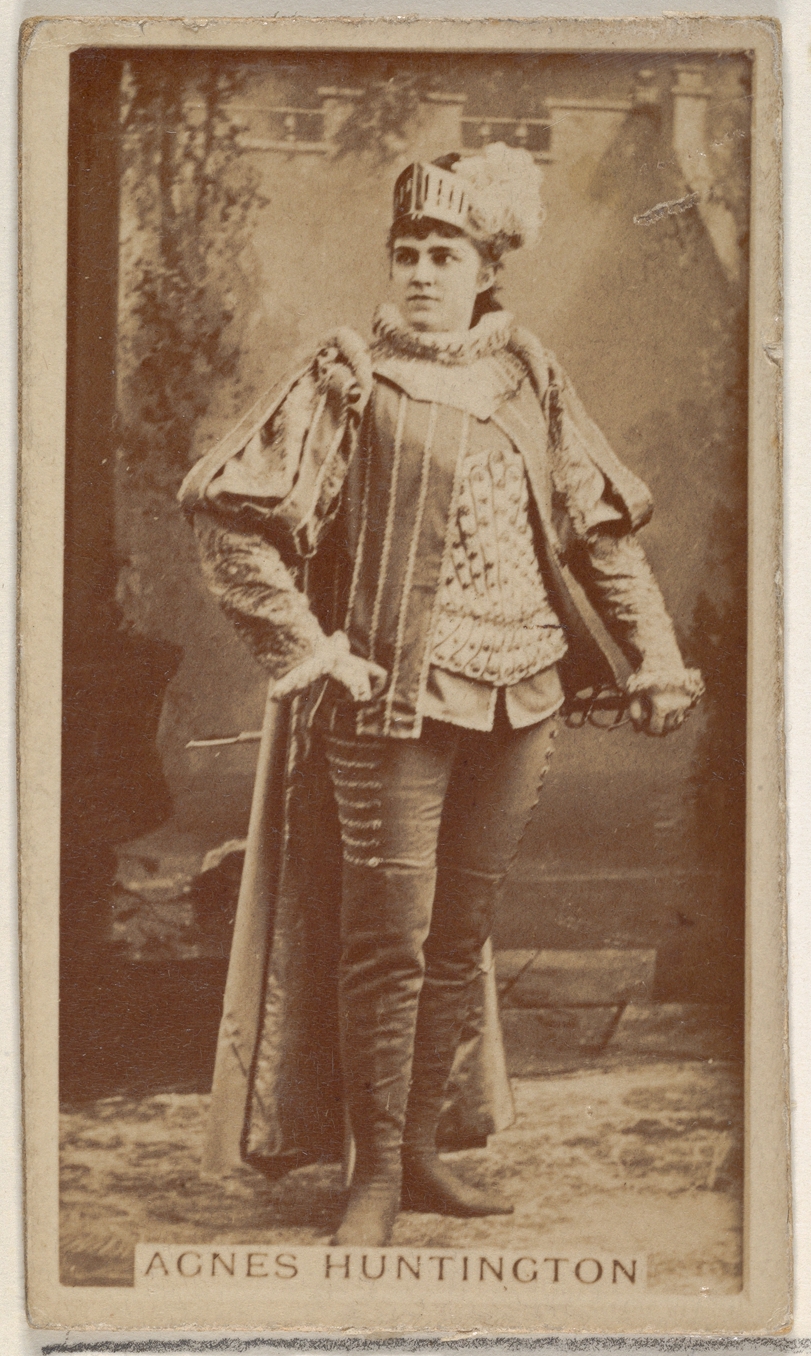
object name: photograph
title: Agnes Huntington, from the Actors and Actresses series (N45, Type 8) for Virginia Brights Cigarettes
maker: allen & ginter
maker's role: publisher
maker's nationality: american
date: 1888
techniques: albumen silver print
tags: portraits,women,actresses